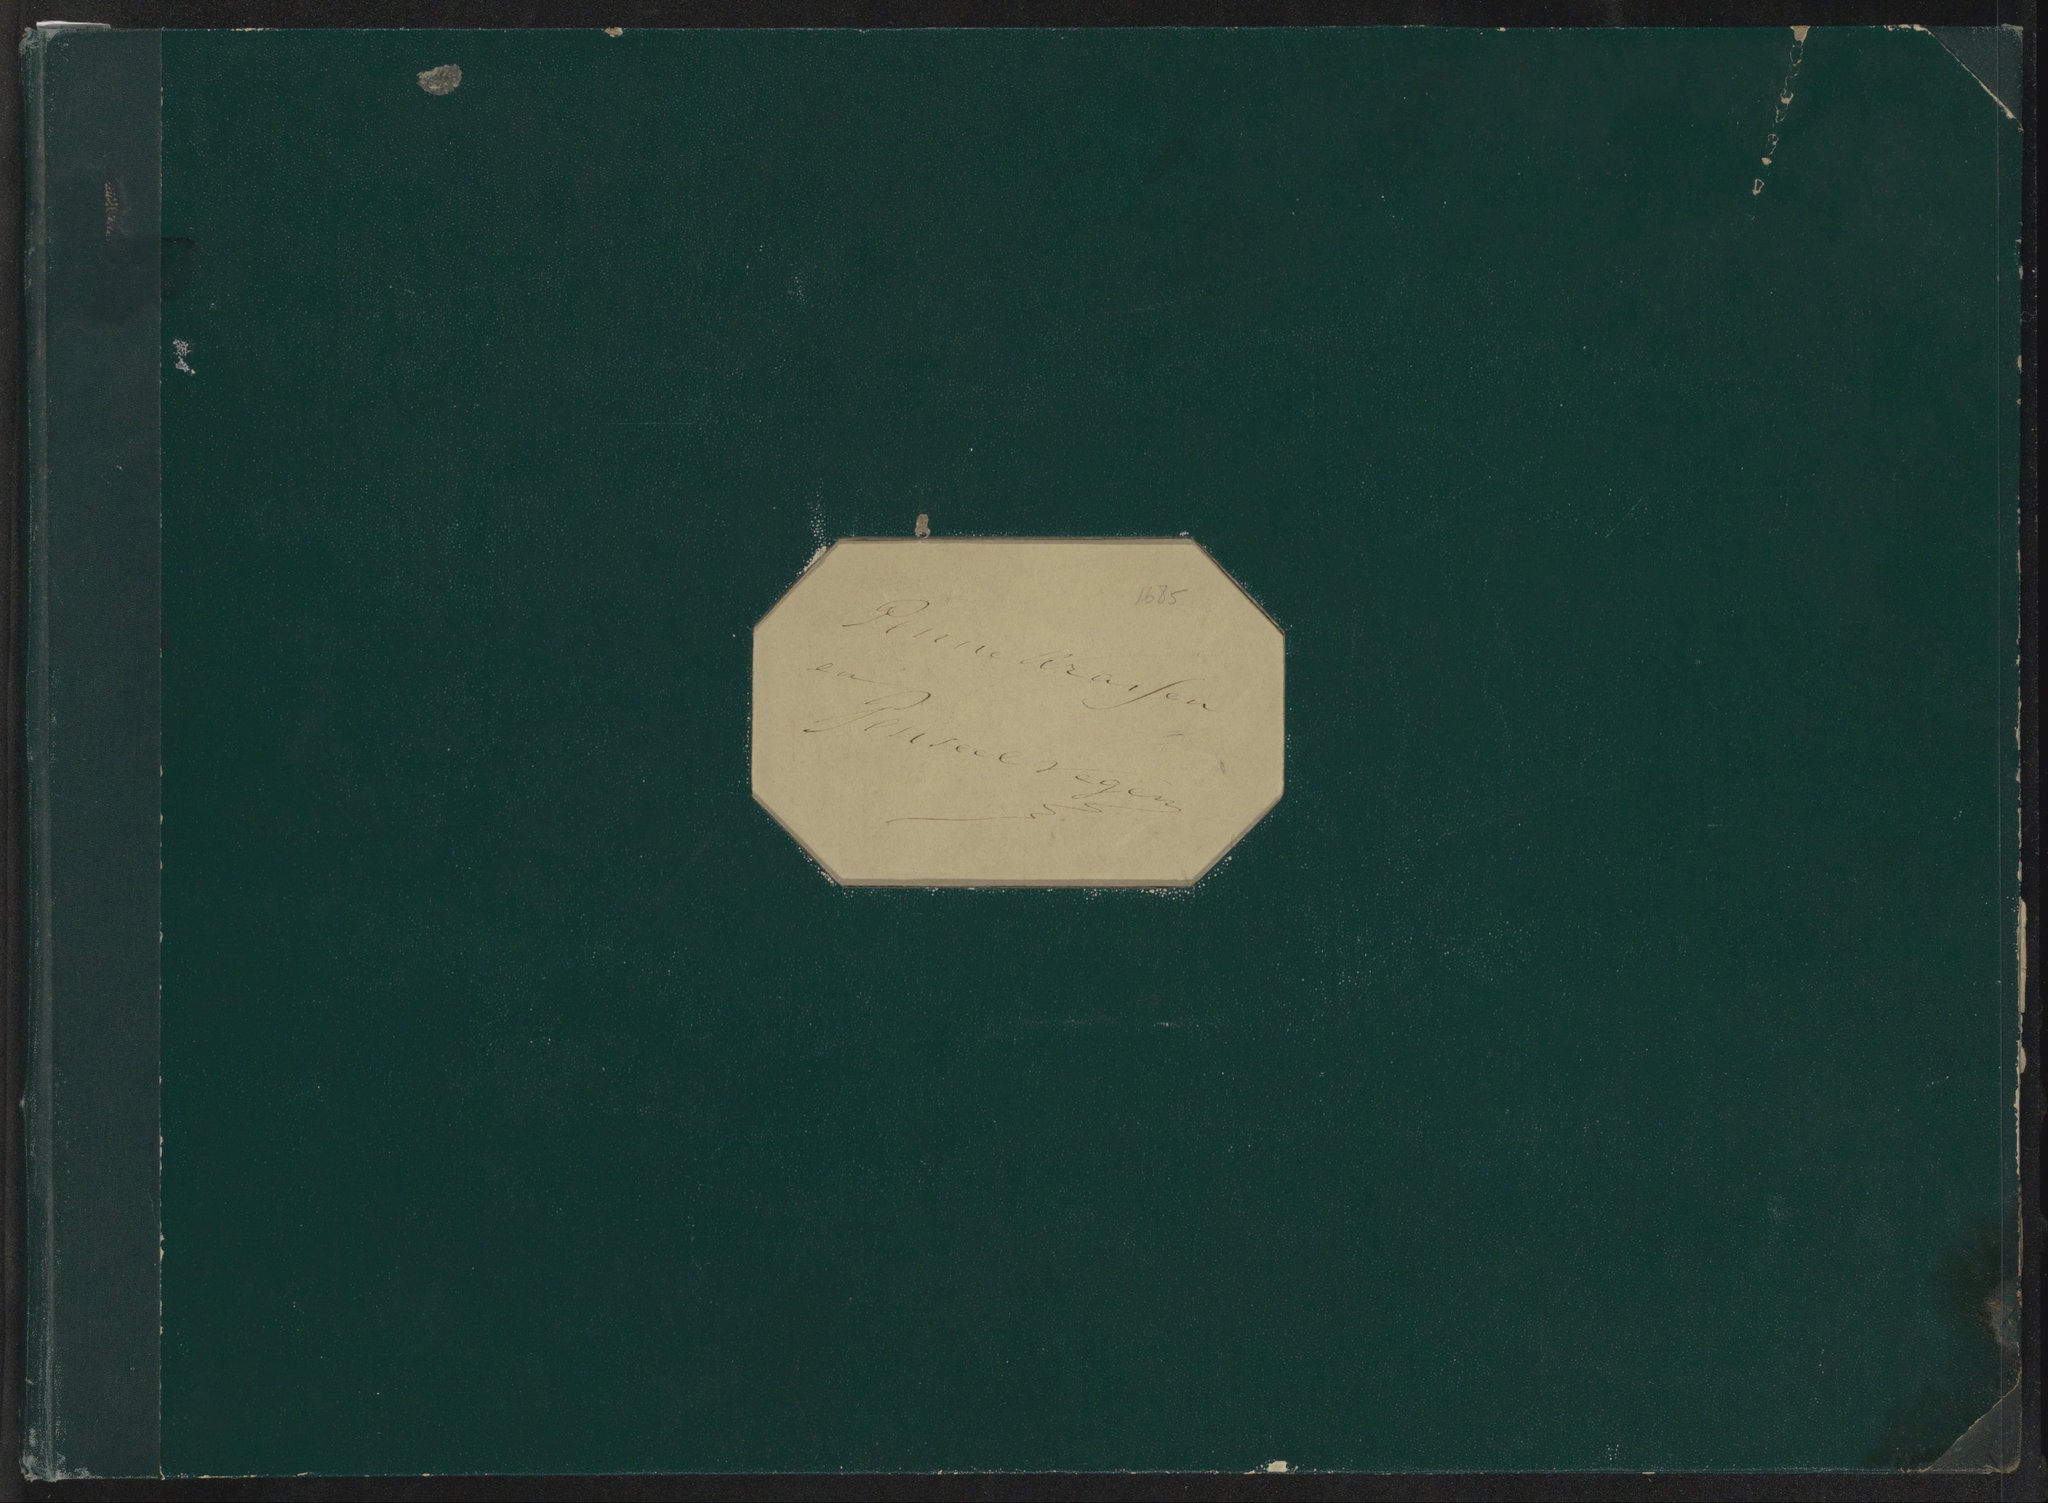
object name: album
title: Album met 35 ingeplakte tekeningen getiteld 'Pennekrassen en Penseelvegen'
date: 1854-1887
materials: cardboard, chalk, ink, linen, paper, pencil, watercolor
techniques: brush, pen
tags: landscapes (+ landscape with figures, staffage), duelling, father time, man with wings and scythe, rotterdam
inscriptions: number: ‘1685’, collector's mark: Lugt 2166, date and inscription: ‘Wel Edel Gestrengen Heer/ B. Janse Johzn/ Oud-Zeeofficier/ met Achting/ A. Ver Huell/ 1887’, inscription: ‘Pennekrassen/ en/ Penseelvegen’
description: Album met 35 ingeplakte tekeningen met voornamelijk menselijke typen, karikaturen en genrevoorstellingen (mogelijk illustraties voor boeken of tijdschriften).